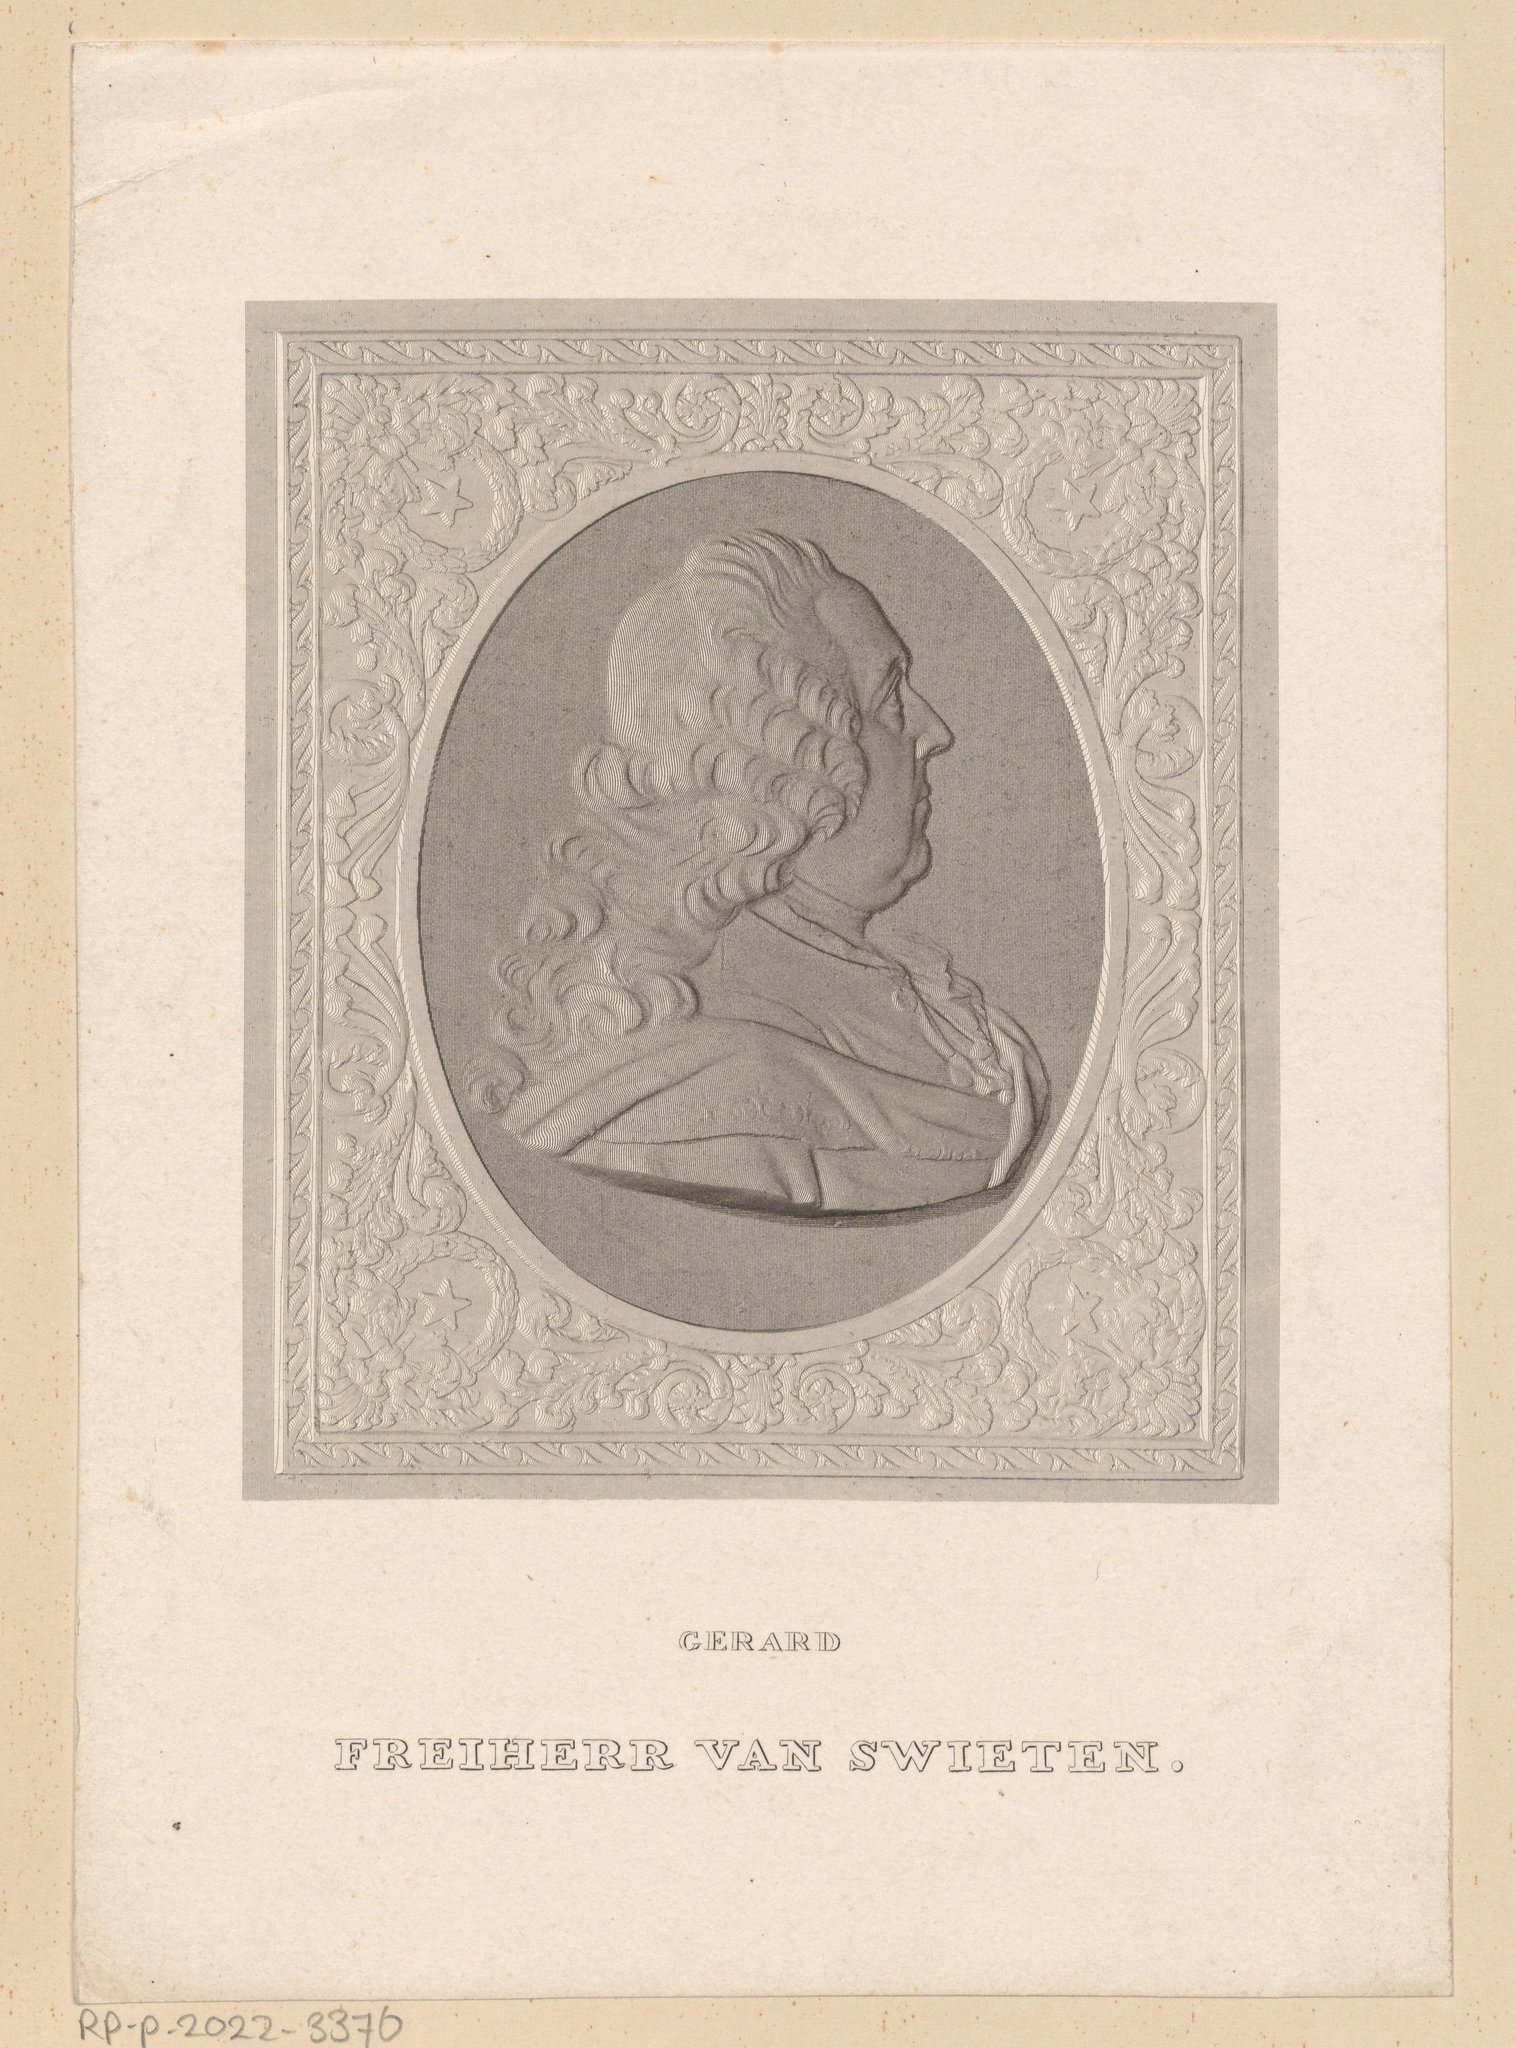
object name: print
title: Portret van Gerard van Swieten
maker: Anonymous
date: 1808-1899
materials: paper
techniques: relief engraving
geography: austria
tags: leiden, historical persons, physician, doctor